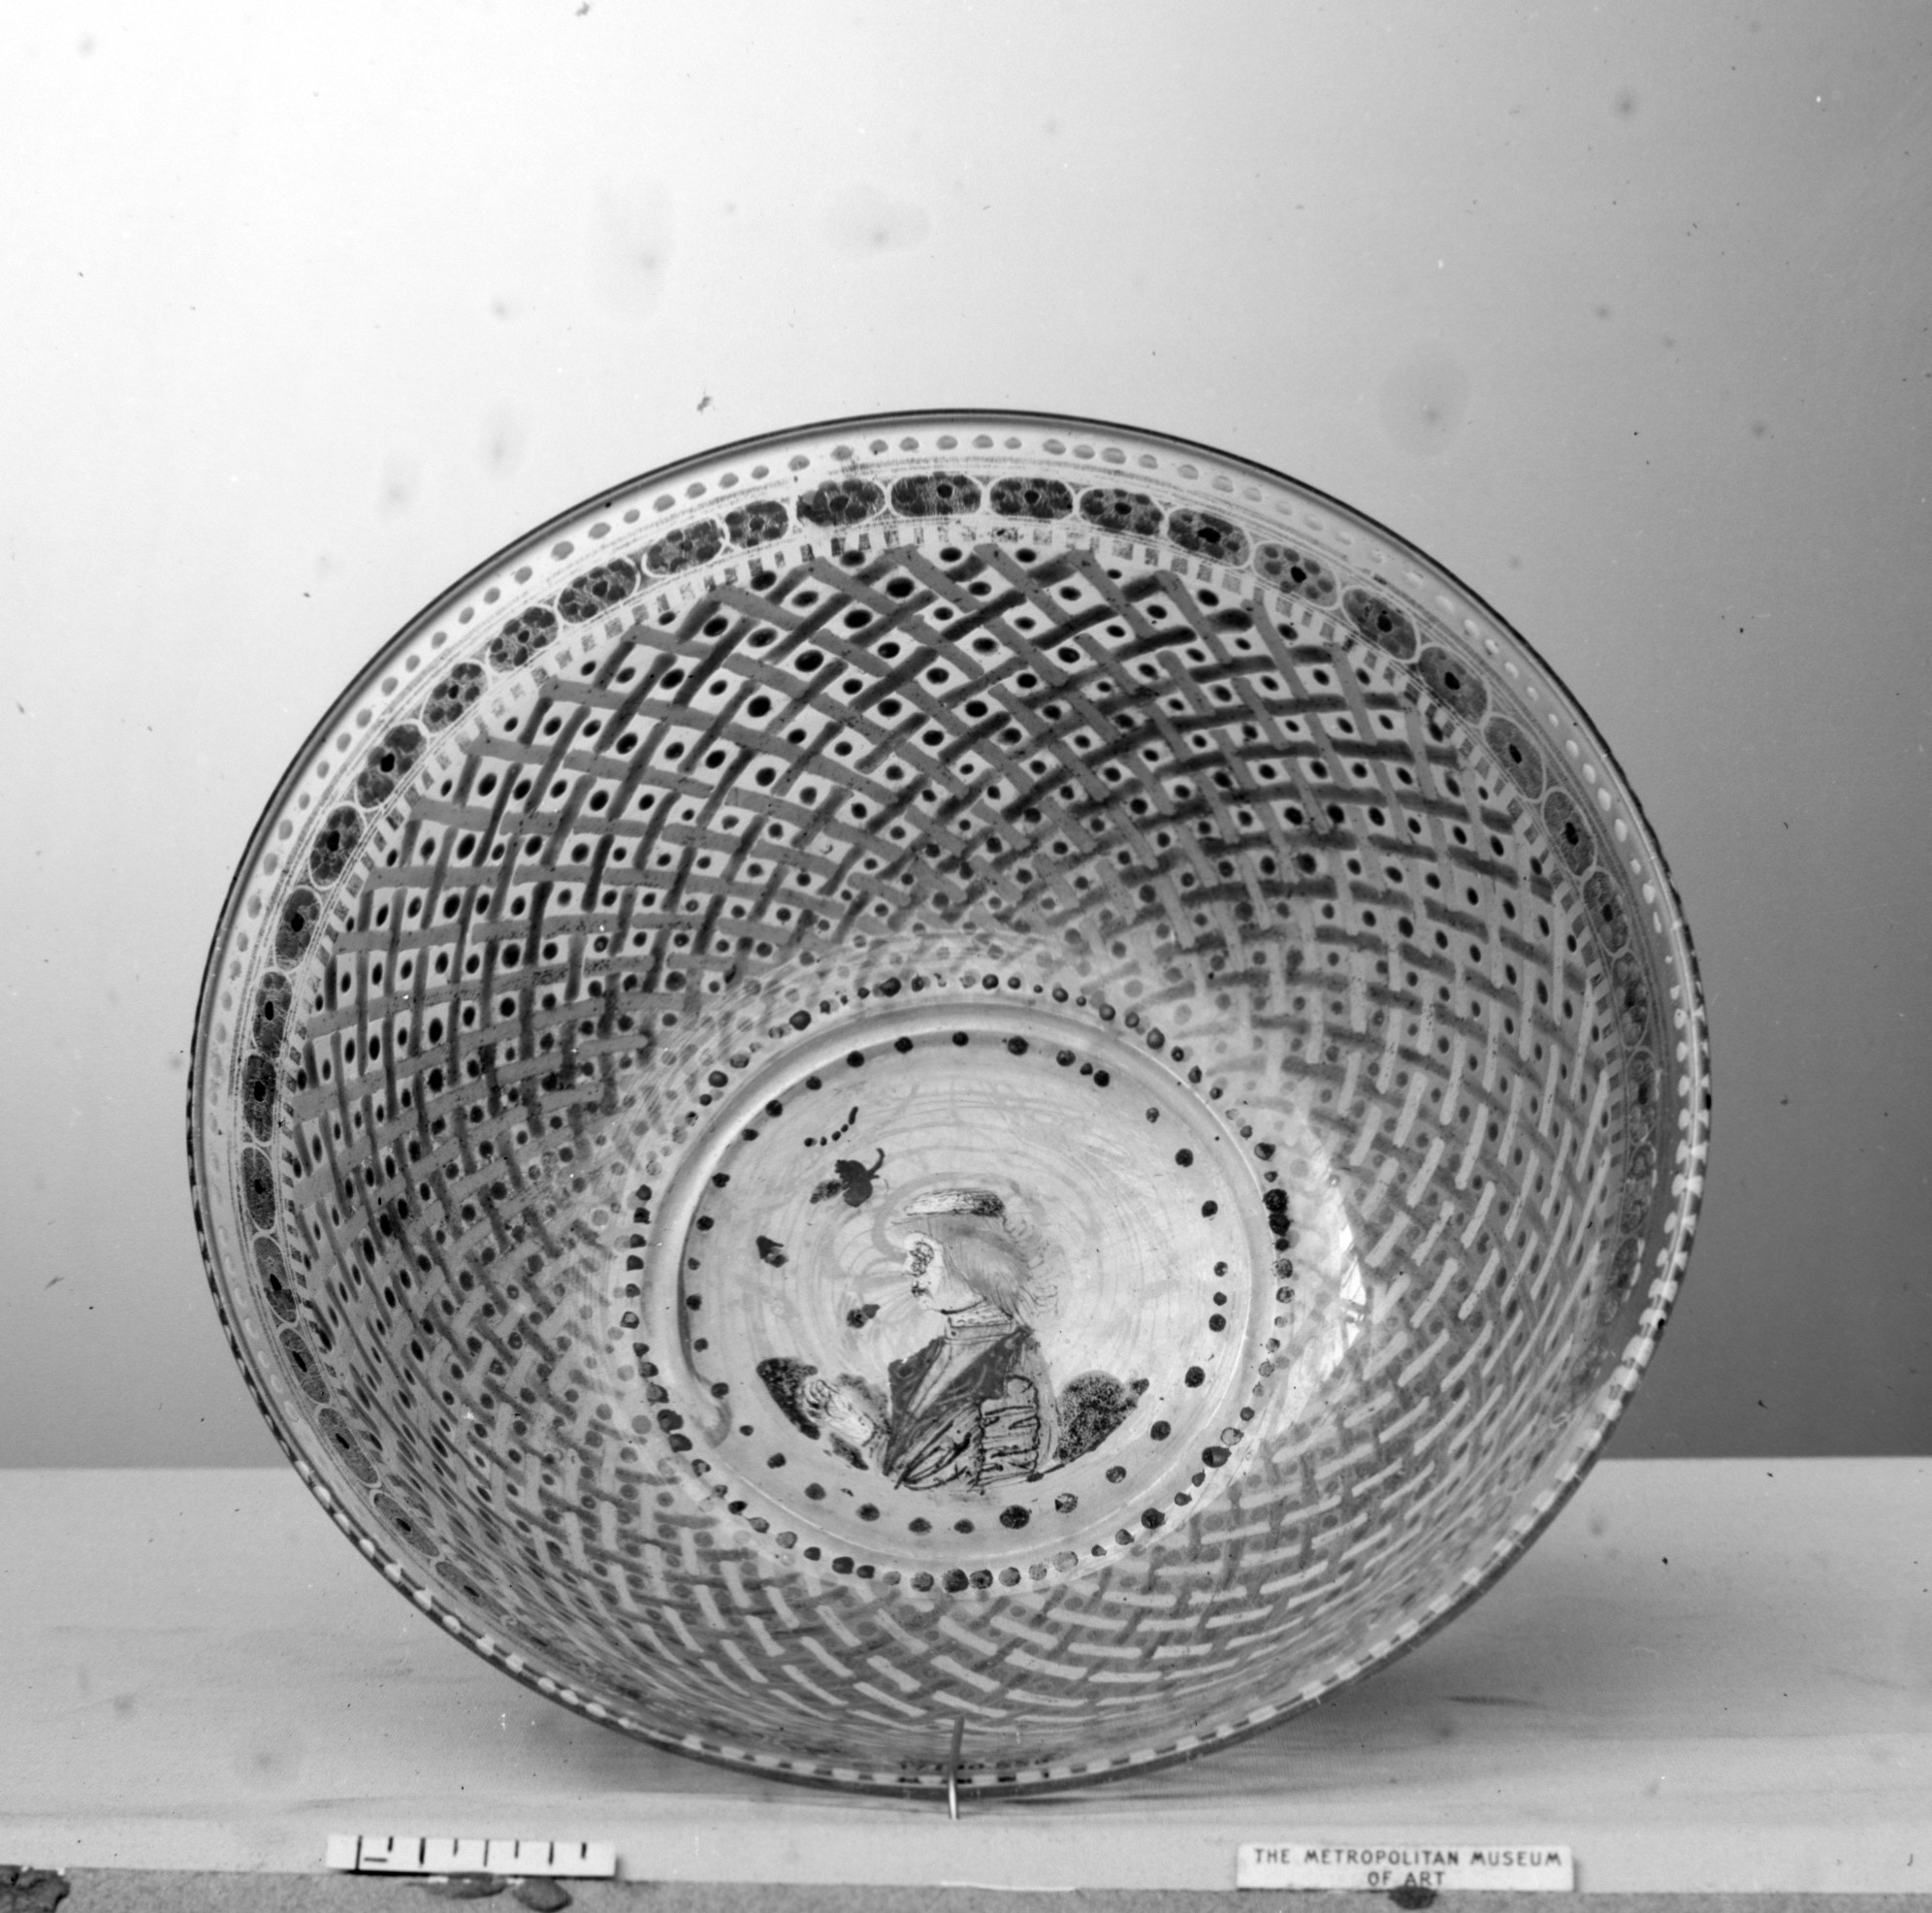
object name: bowl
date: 1467-1500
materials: gilt, glass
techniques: enamel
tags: human figures,profiles